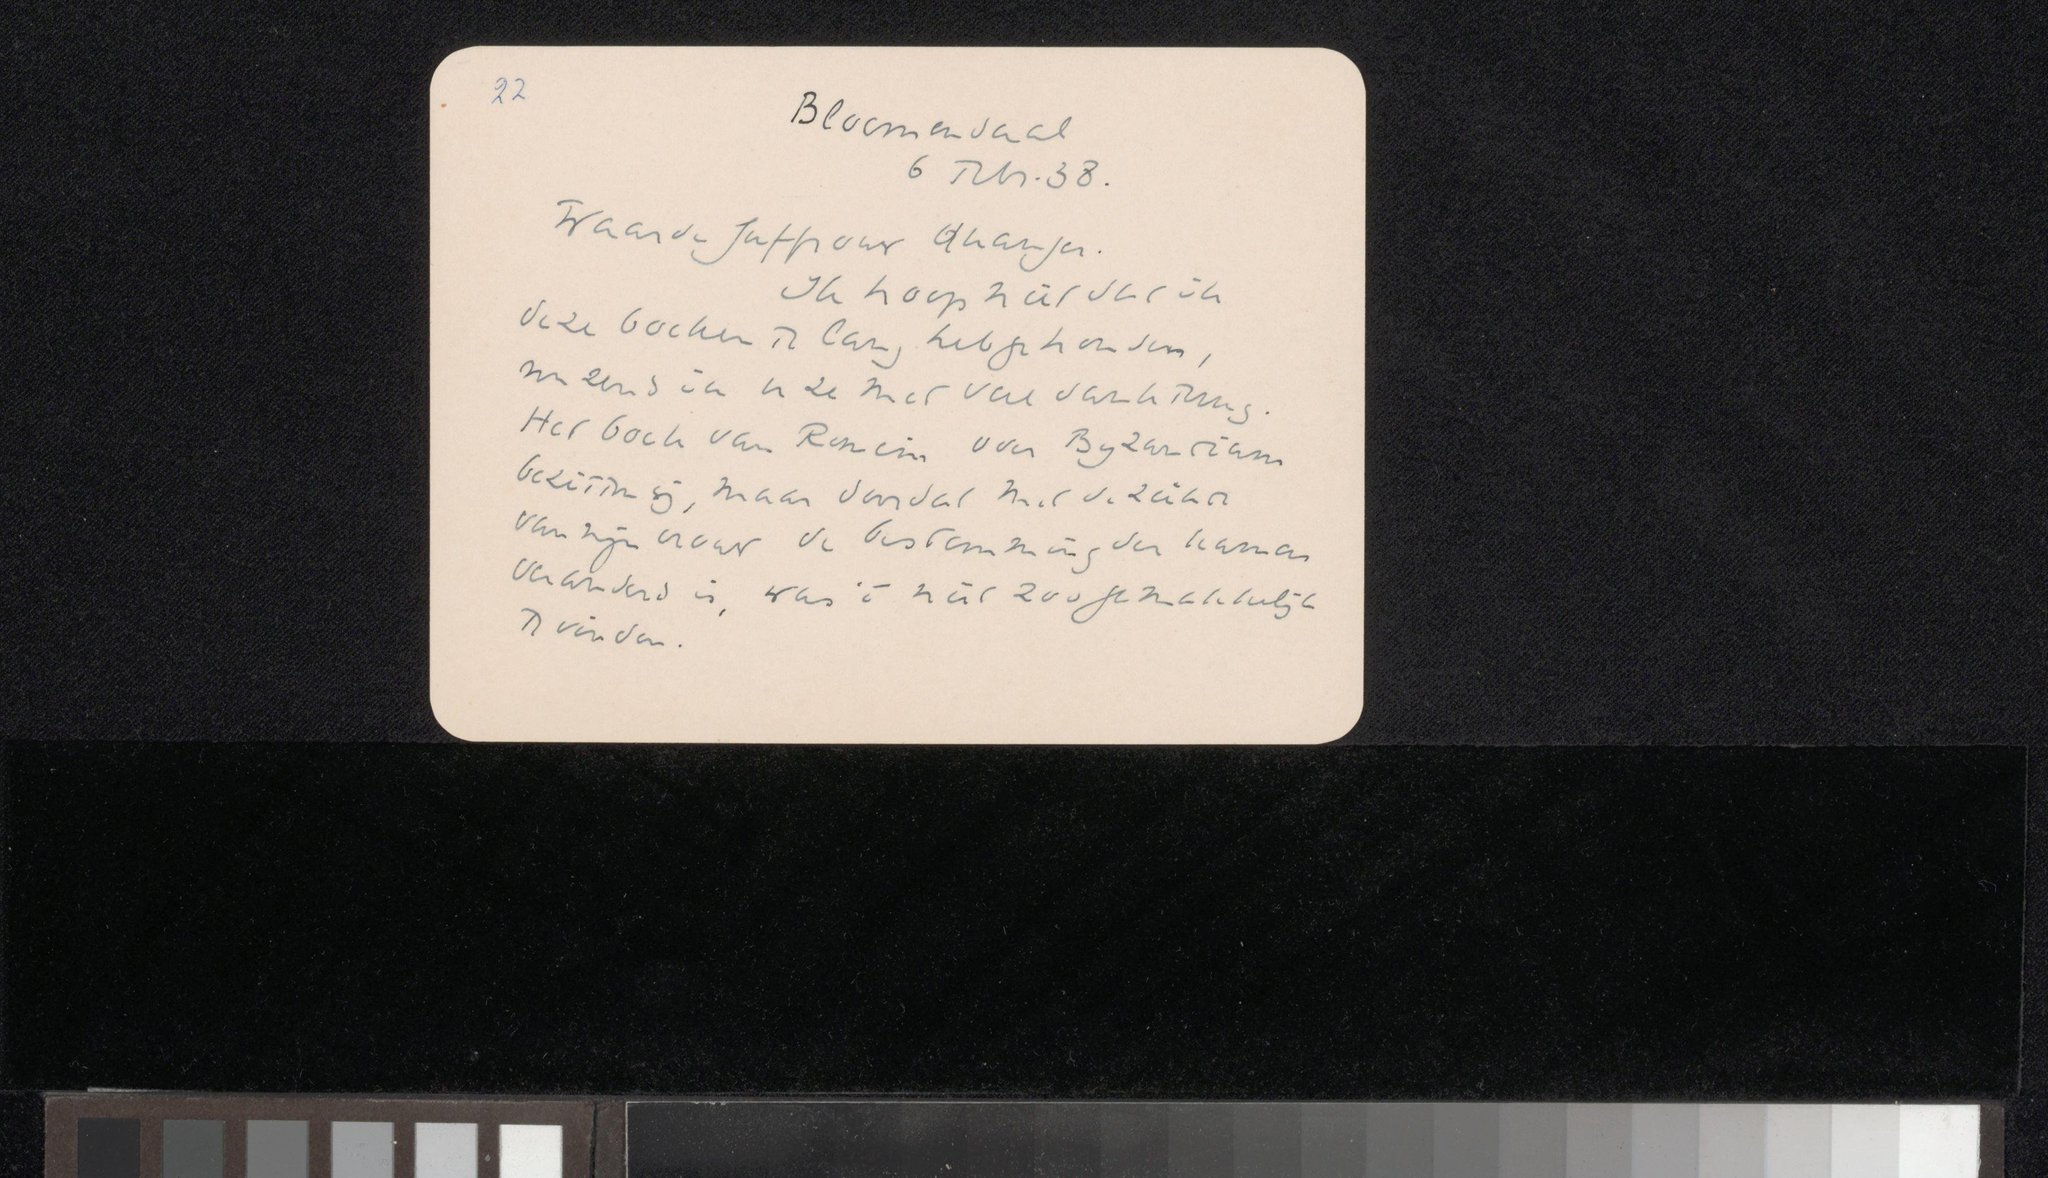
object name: letter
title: Brief aan Marisa Quanjer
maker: richard nicolaüs roland holst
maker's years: 1868-1938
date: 1938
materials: ink, paper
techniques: pen, writing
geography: bloemendaal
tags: applied arts, arts and crafts; industrial design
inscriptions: collector's mark: ‘RPK’